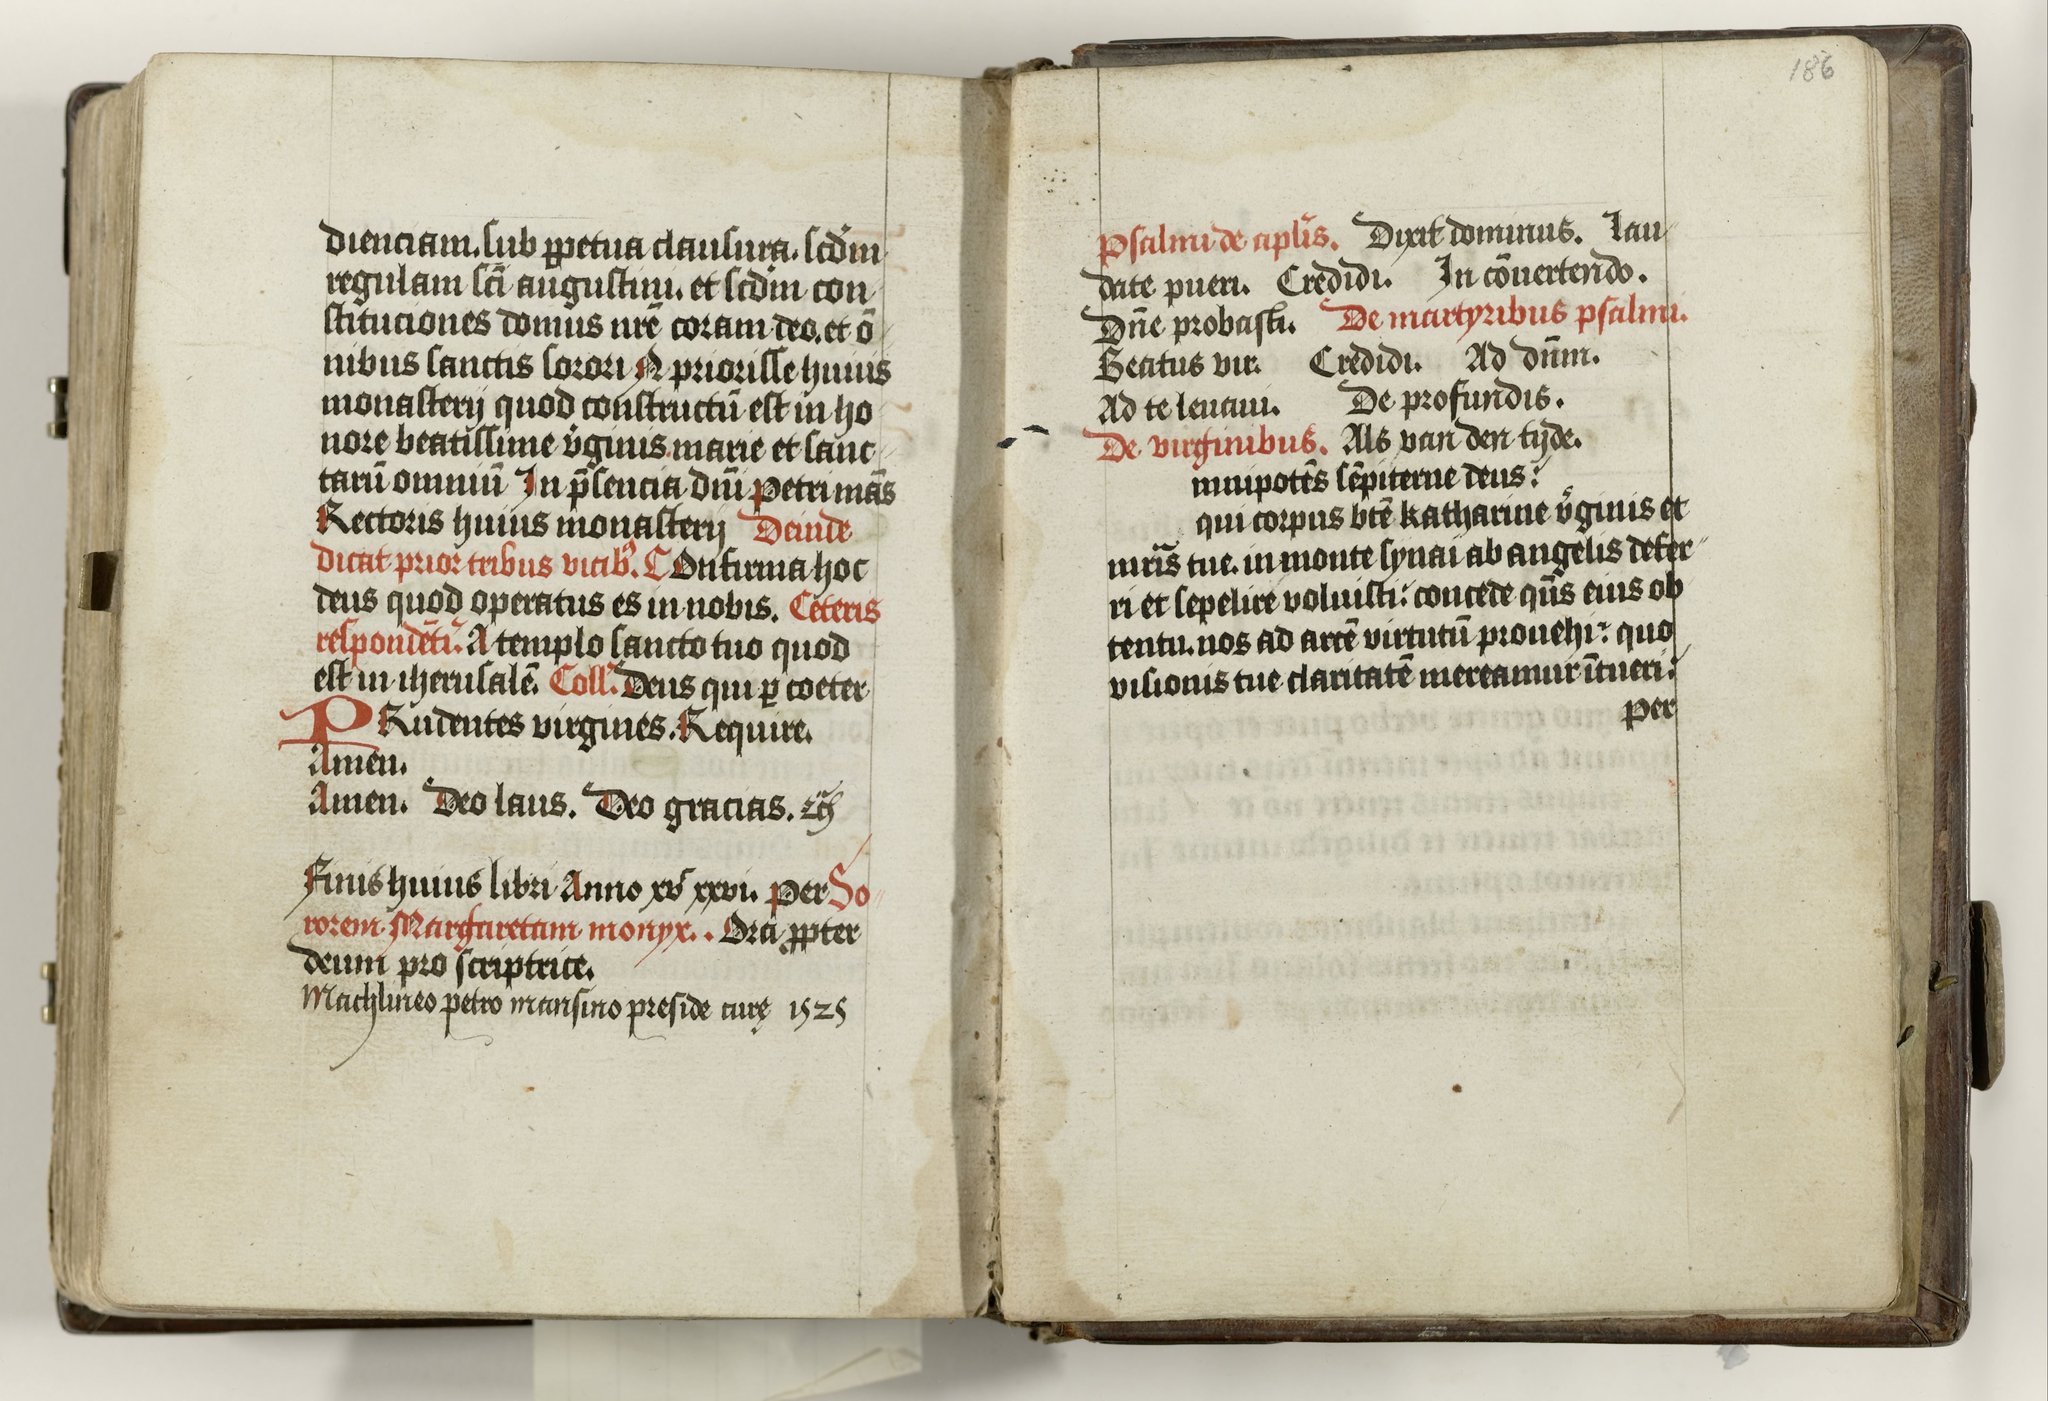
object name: miniature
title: Psalter en brevier (gedeeltes) in het Latijn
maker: Anonymous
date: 1500-1600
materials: paint, paper, parchment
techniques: pen in colors, brush in colors